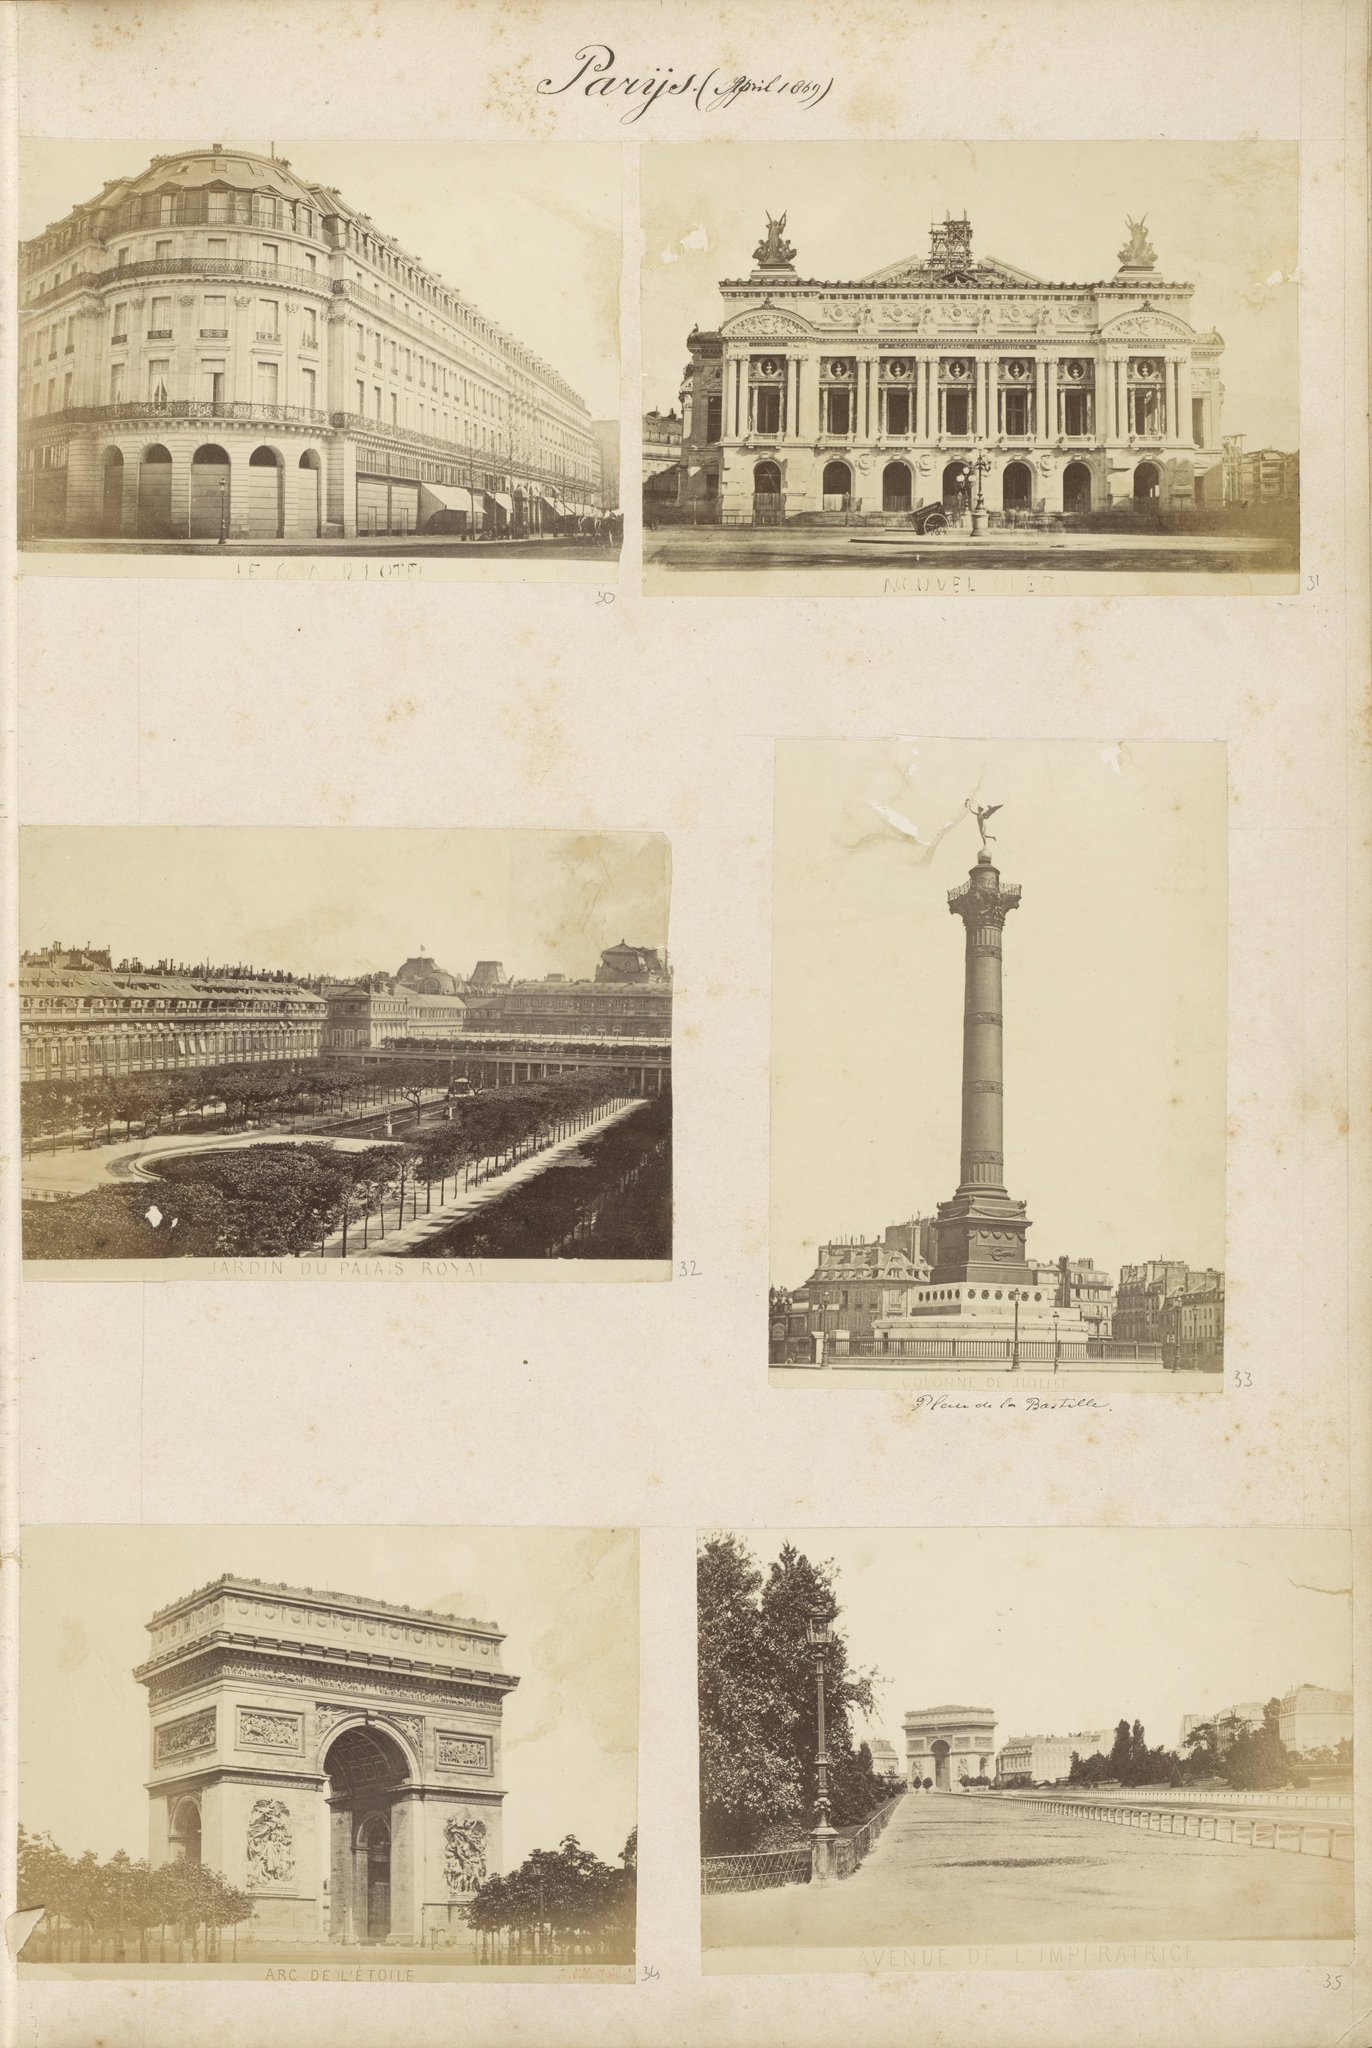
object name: album leaf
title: Nouvel Opéra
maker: Anonymous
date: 1804-1869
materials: paper, photographic support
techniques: albumen print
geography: paris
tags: opera house, paris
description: Onderdeel van Fotoalbum van Robert Daniel Crommelin (1841-1907).